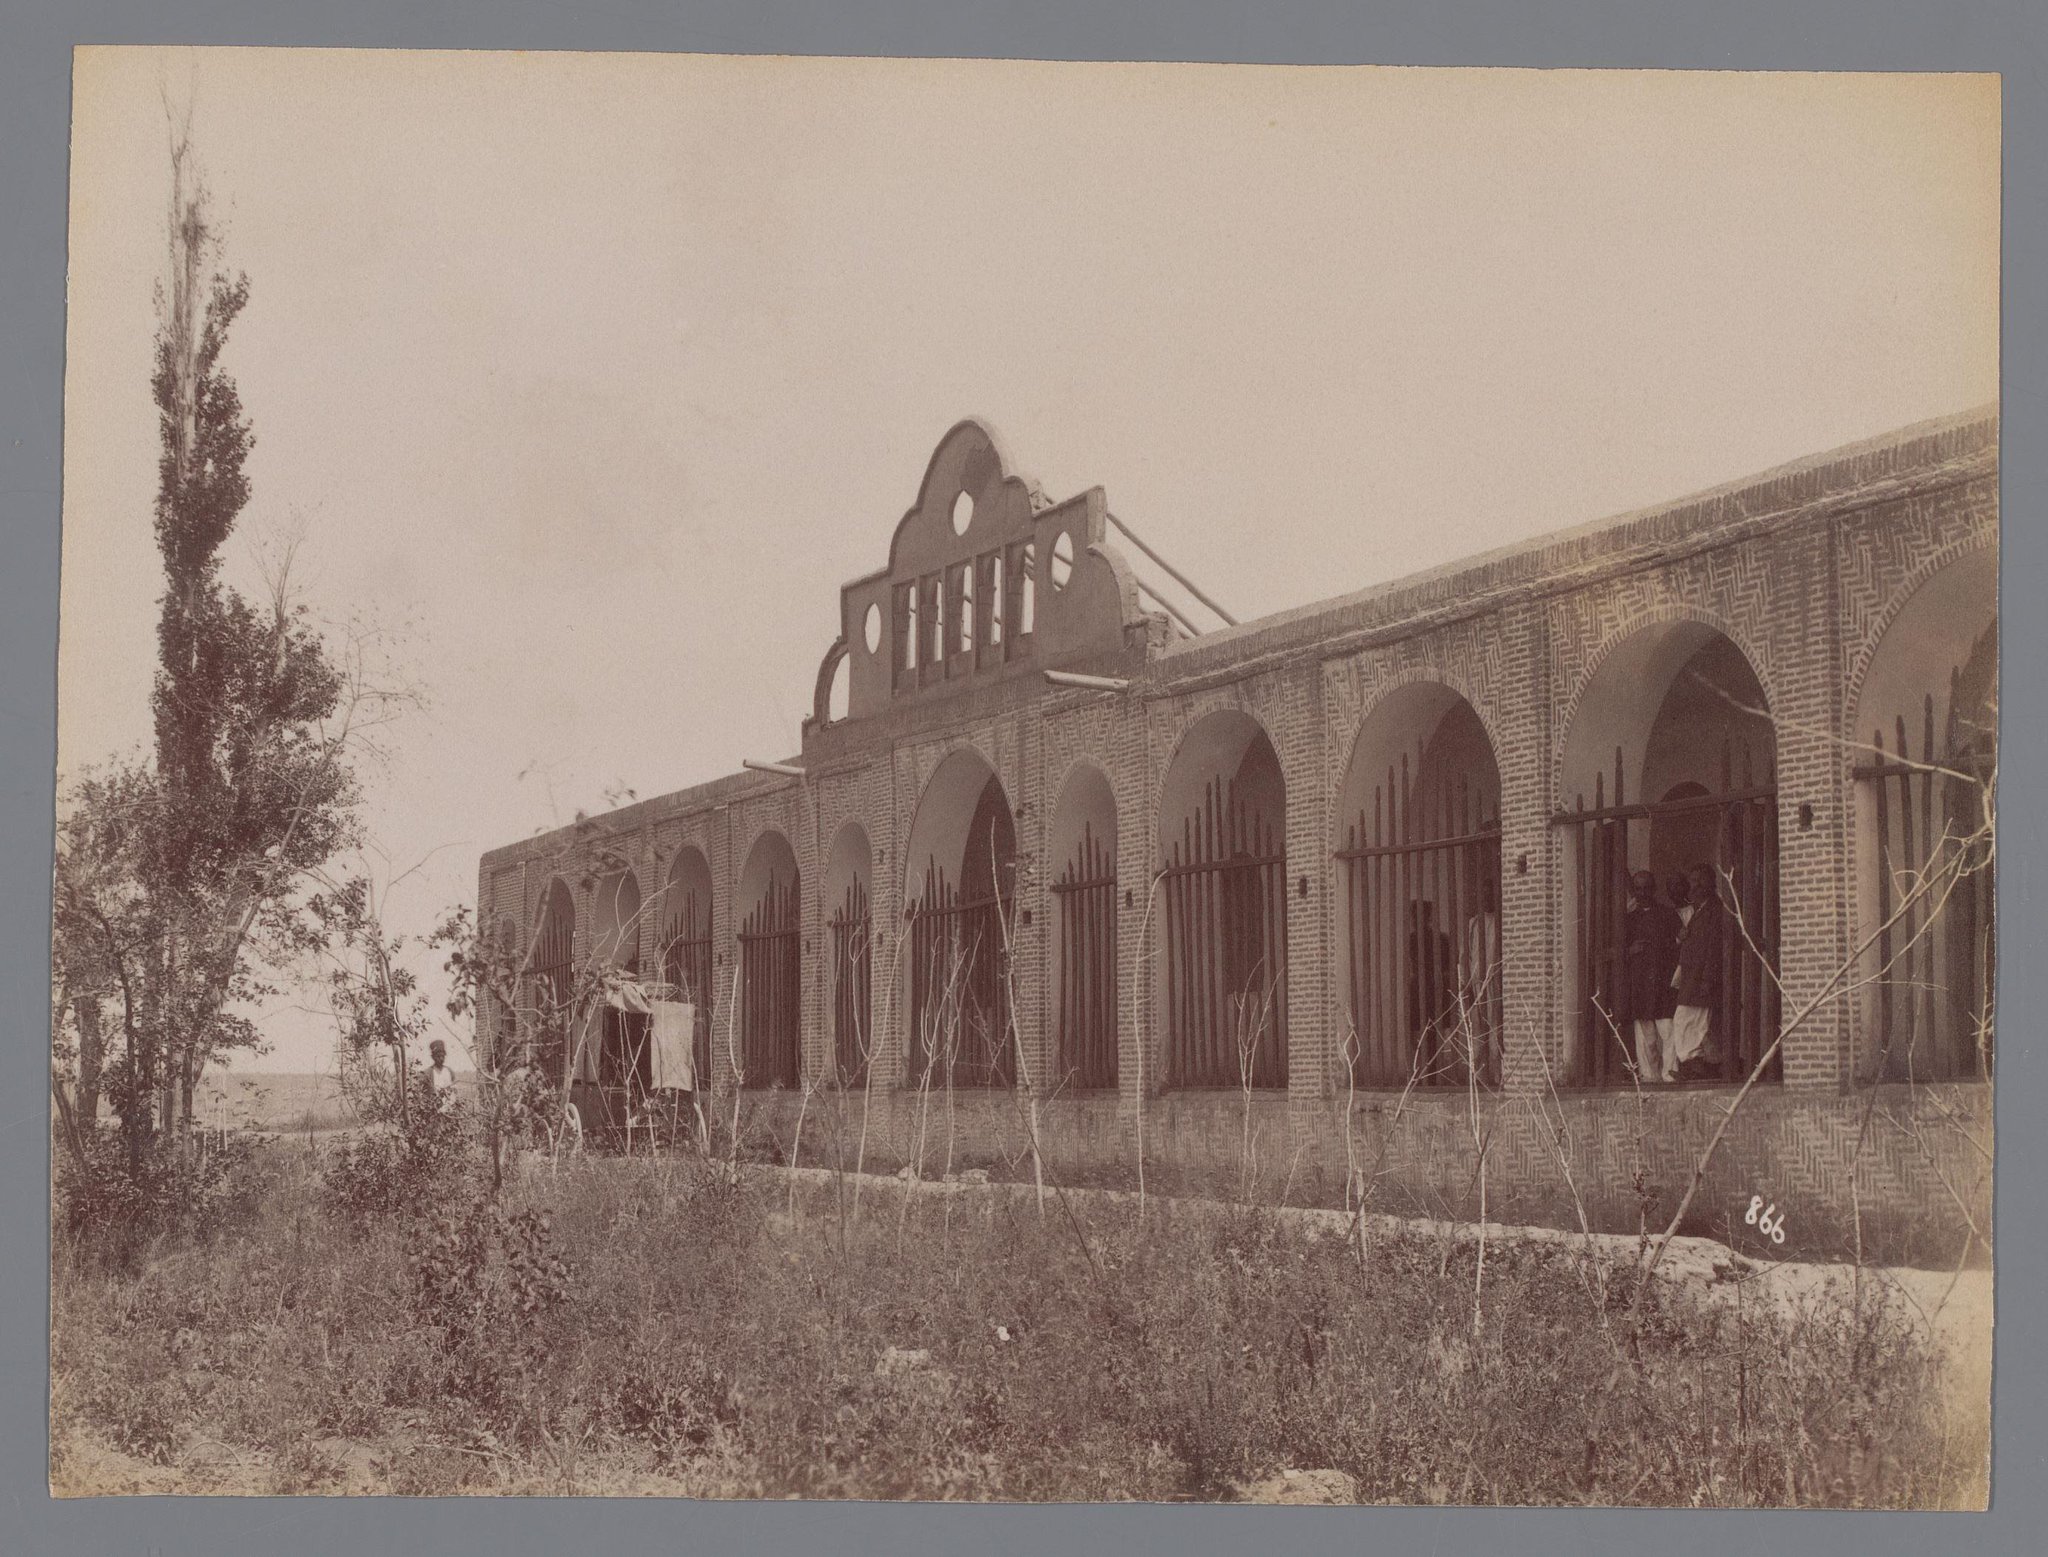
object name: photograph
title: Gezicht op gebouw [moskee?], "La Route de Kaznin/Kazrin"[?], Iran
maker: antoine sevruguin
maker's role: fotograaf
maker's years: 1840-1933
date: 1885-1910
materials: paper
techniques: albumen print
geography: iran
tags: iran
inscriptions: number: ‘257’, number: ‘866’, inscription: ‘La route de Kaznin//Kichelagh [?]’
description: Gezicht op gebouw [moskee?], "La Route de Kaznin/Kazrin"[?], Iran. Vergelijk RP-F-00-6146 en RP-F-00-6155: zelfde gebouw.